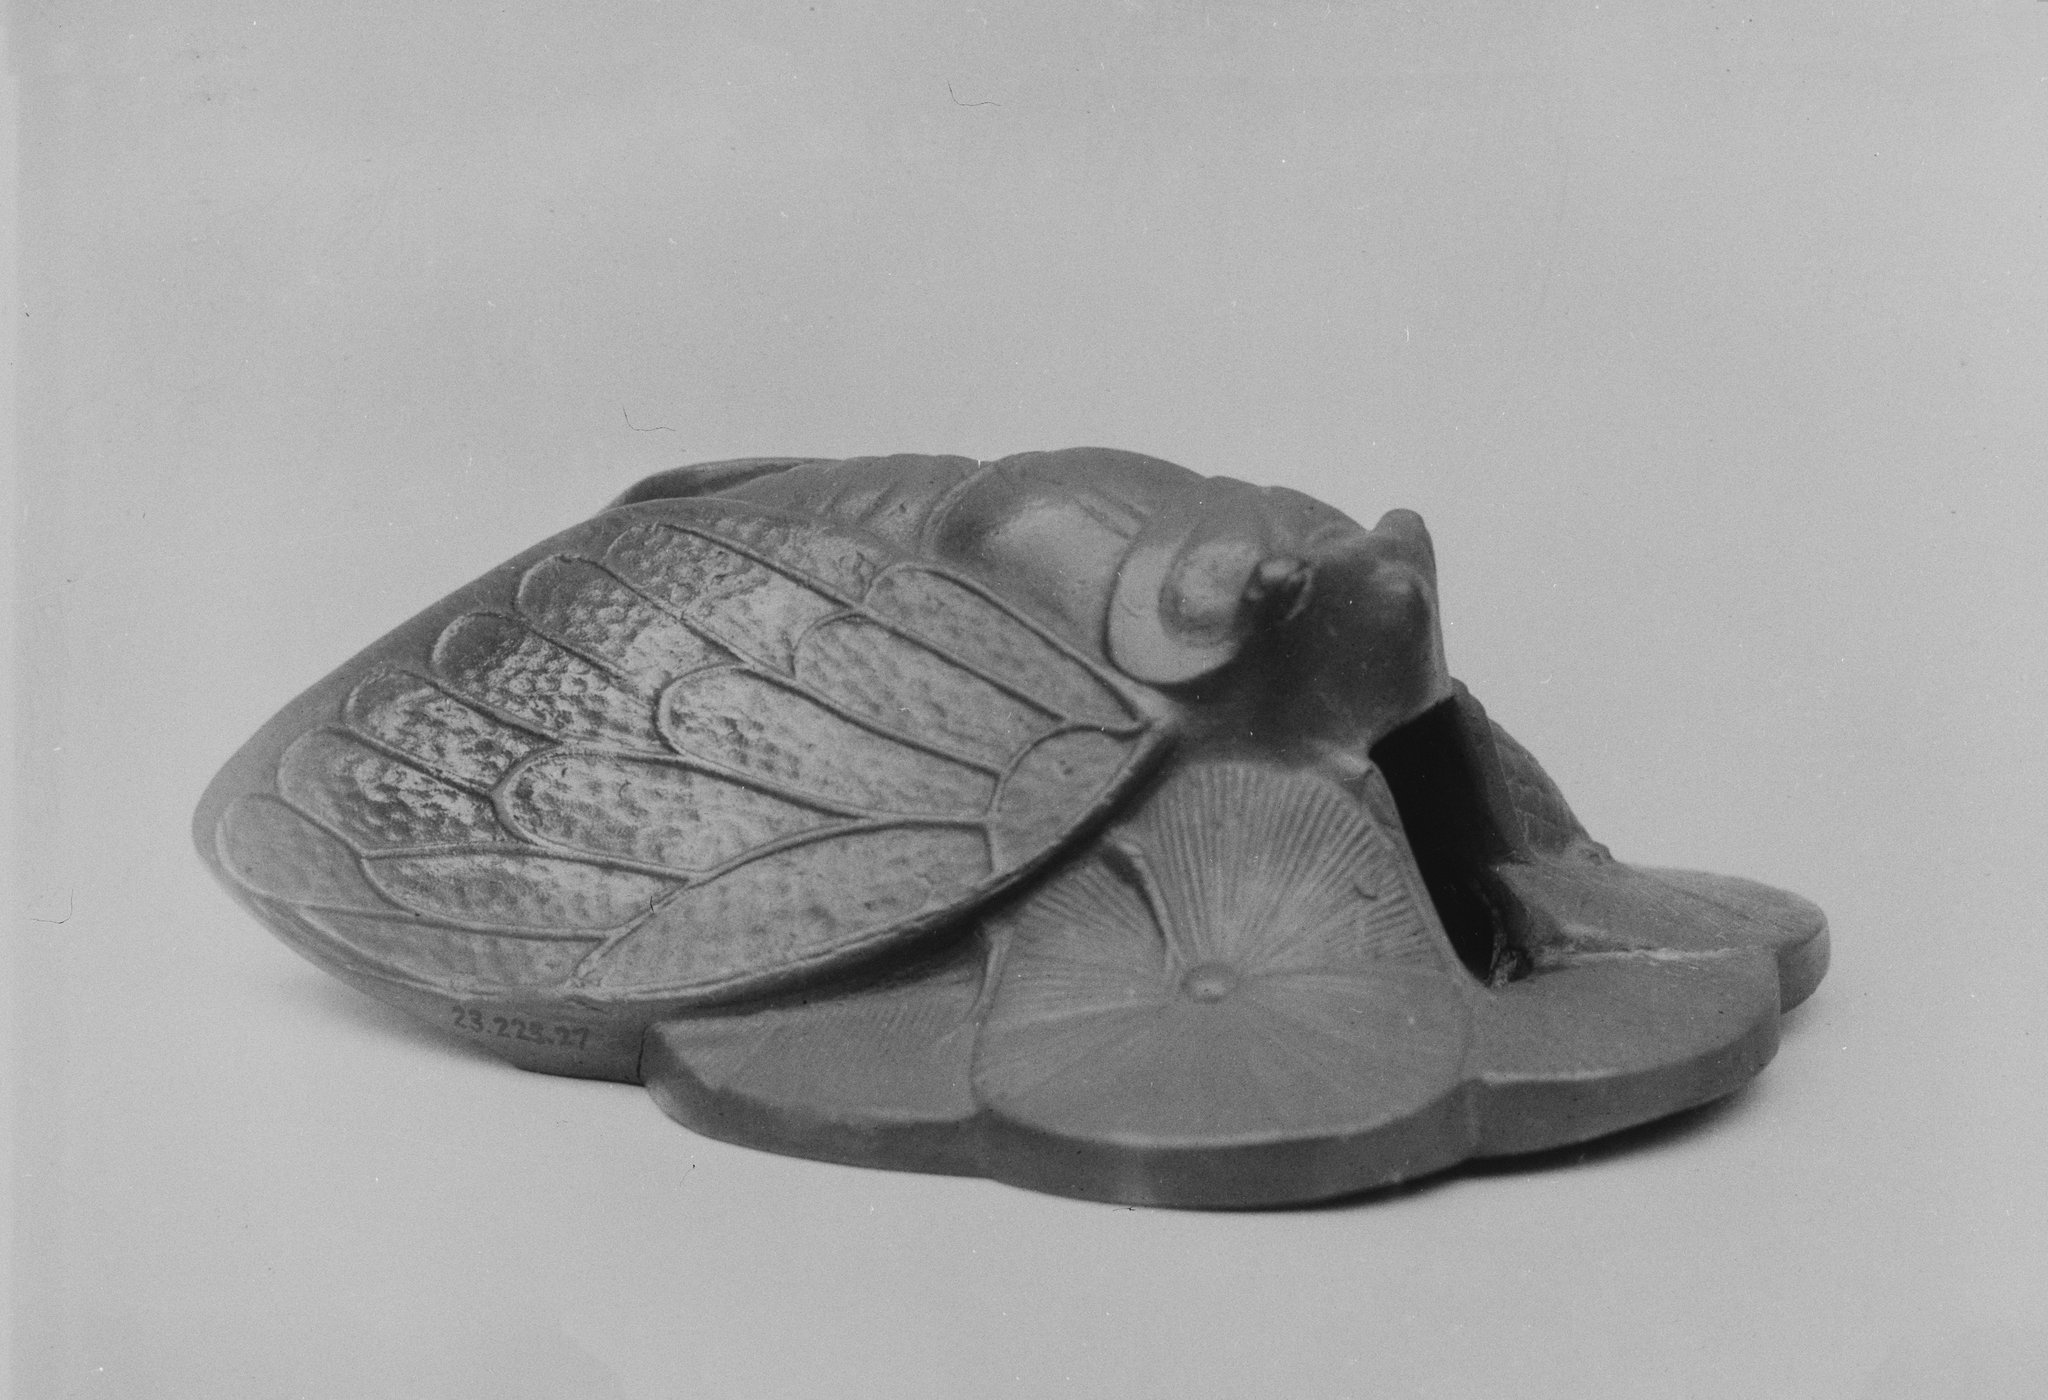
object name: vase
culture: japanese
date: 1650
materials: glaze, stoneware